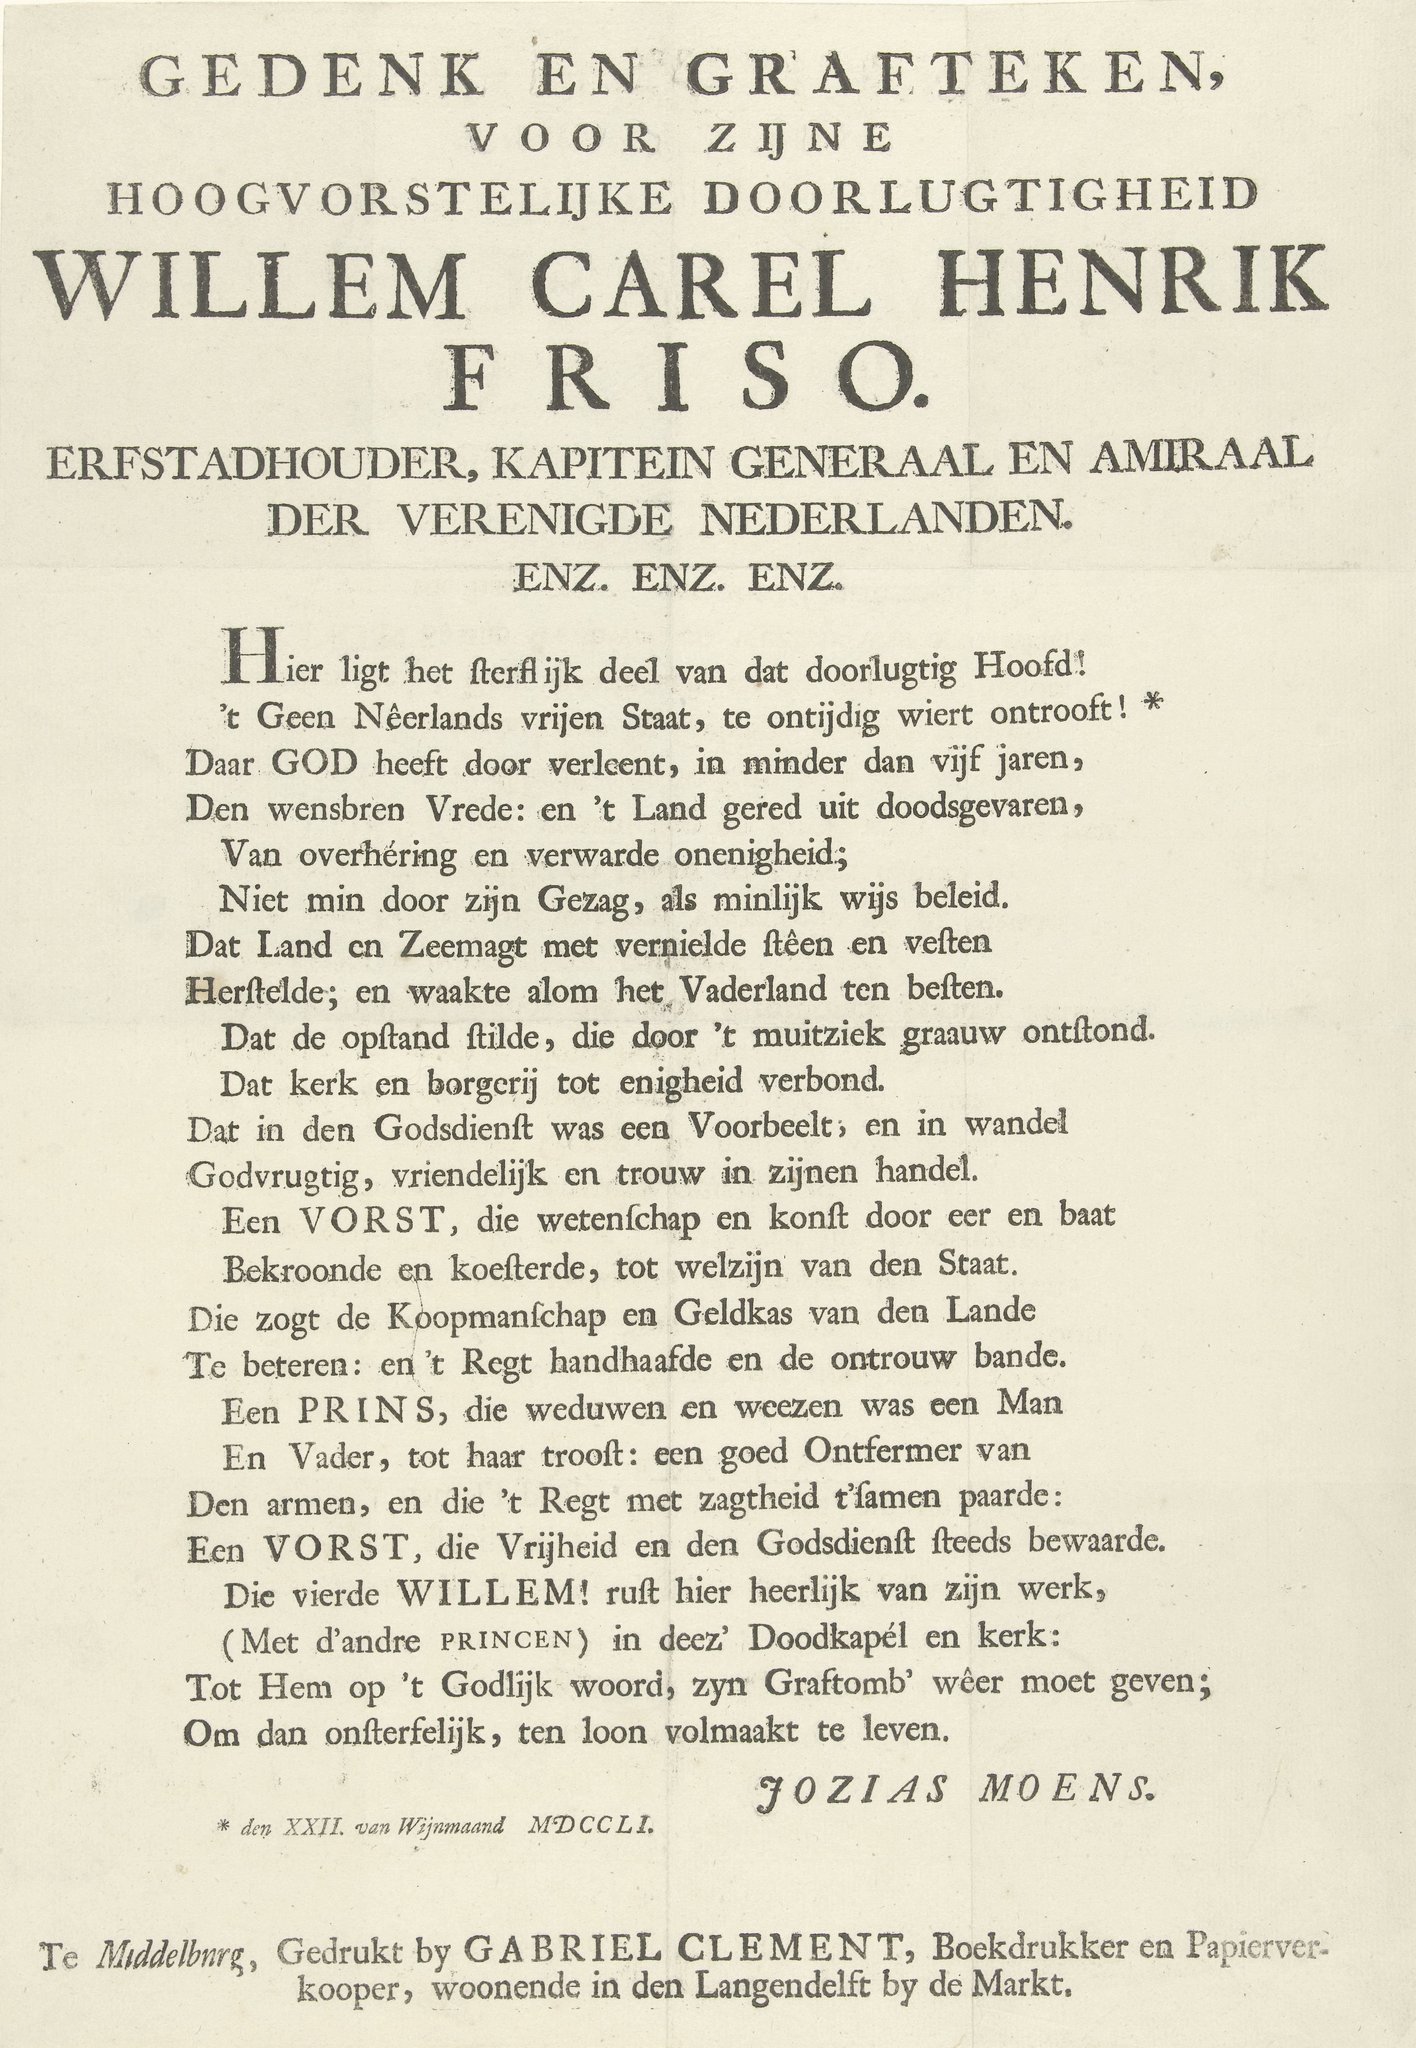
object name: text sheet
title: Gedenkvers voor Willem IV, 1751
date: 1751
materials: paper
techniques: letterpress printing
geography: middelburg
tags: the hague, willem iv (prins van oranje-nassau)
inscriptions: collector's mark: Lugt 2228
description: Tekstblad met een vers op het overlijden van prins Willem IV op 22 oktober 1751.